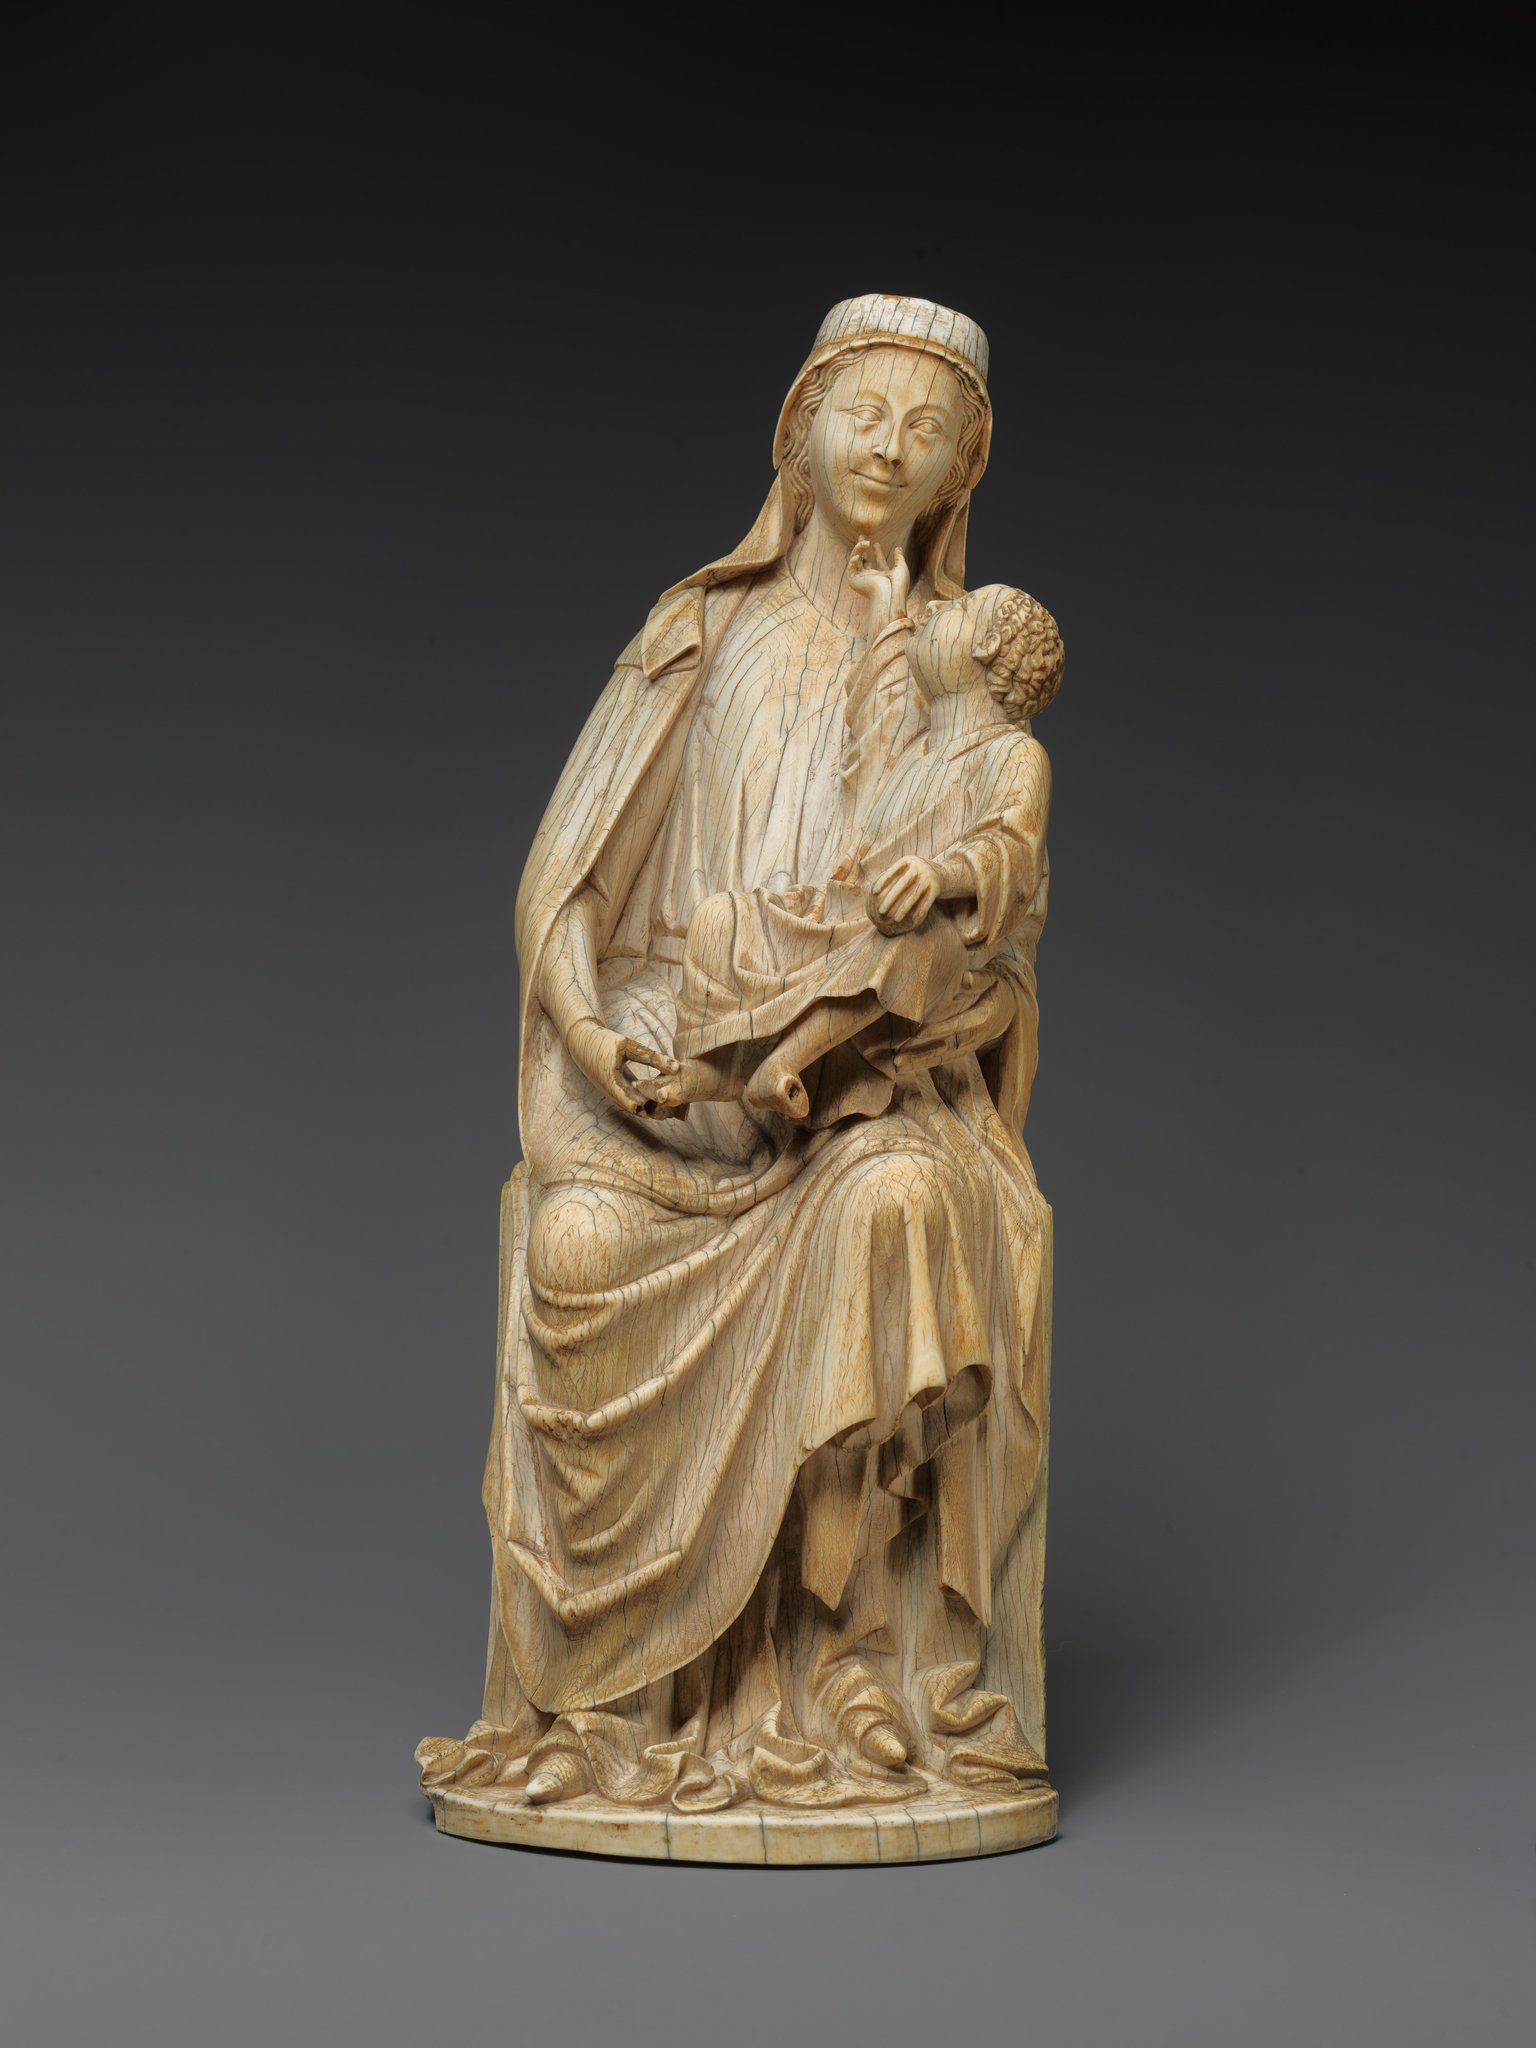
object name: statuette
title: Virgin and Child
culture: french, north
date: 1250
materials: ivory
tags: madonna and child